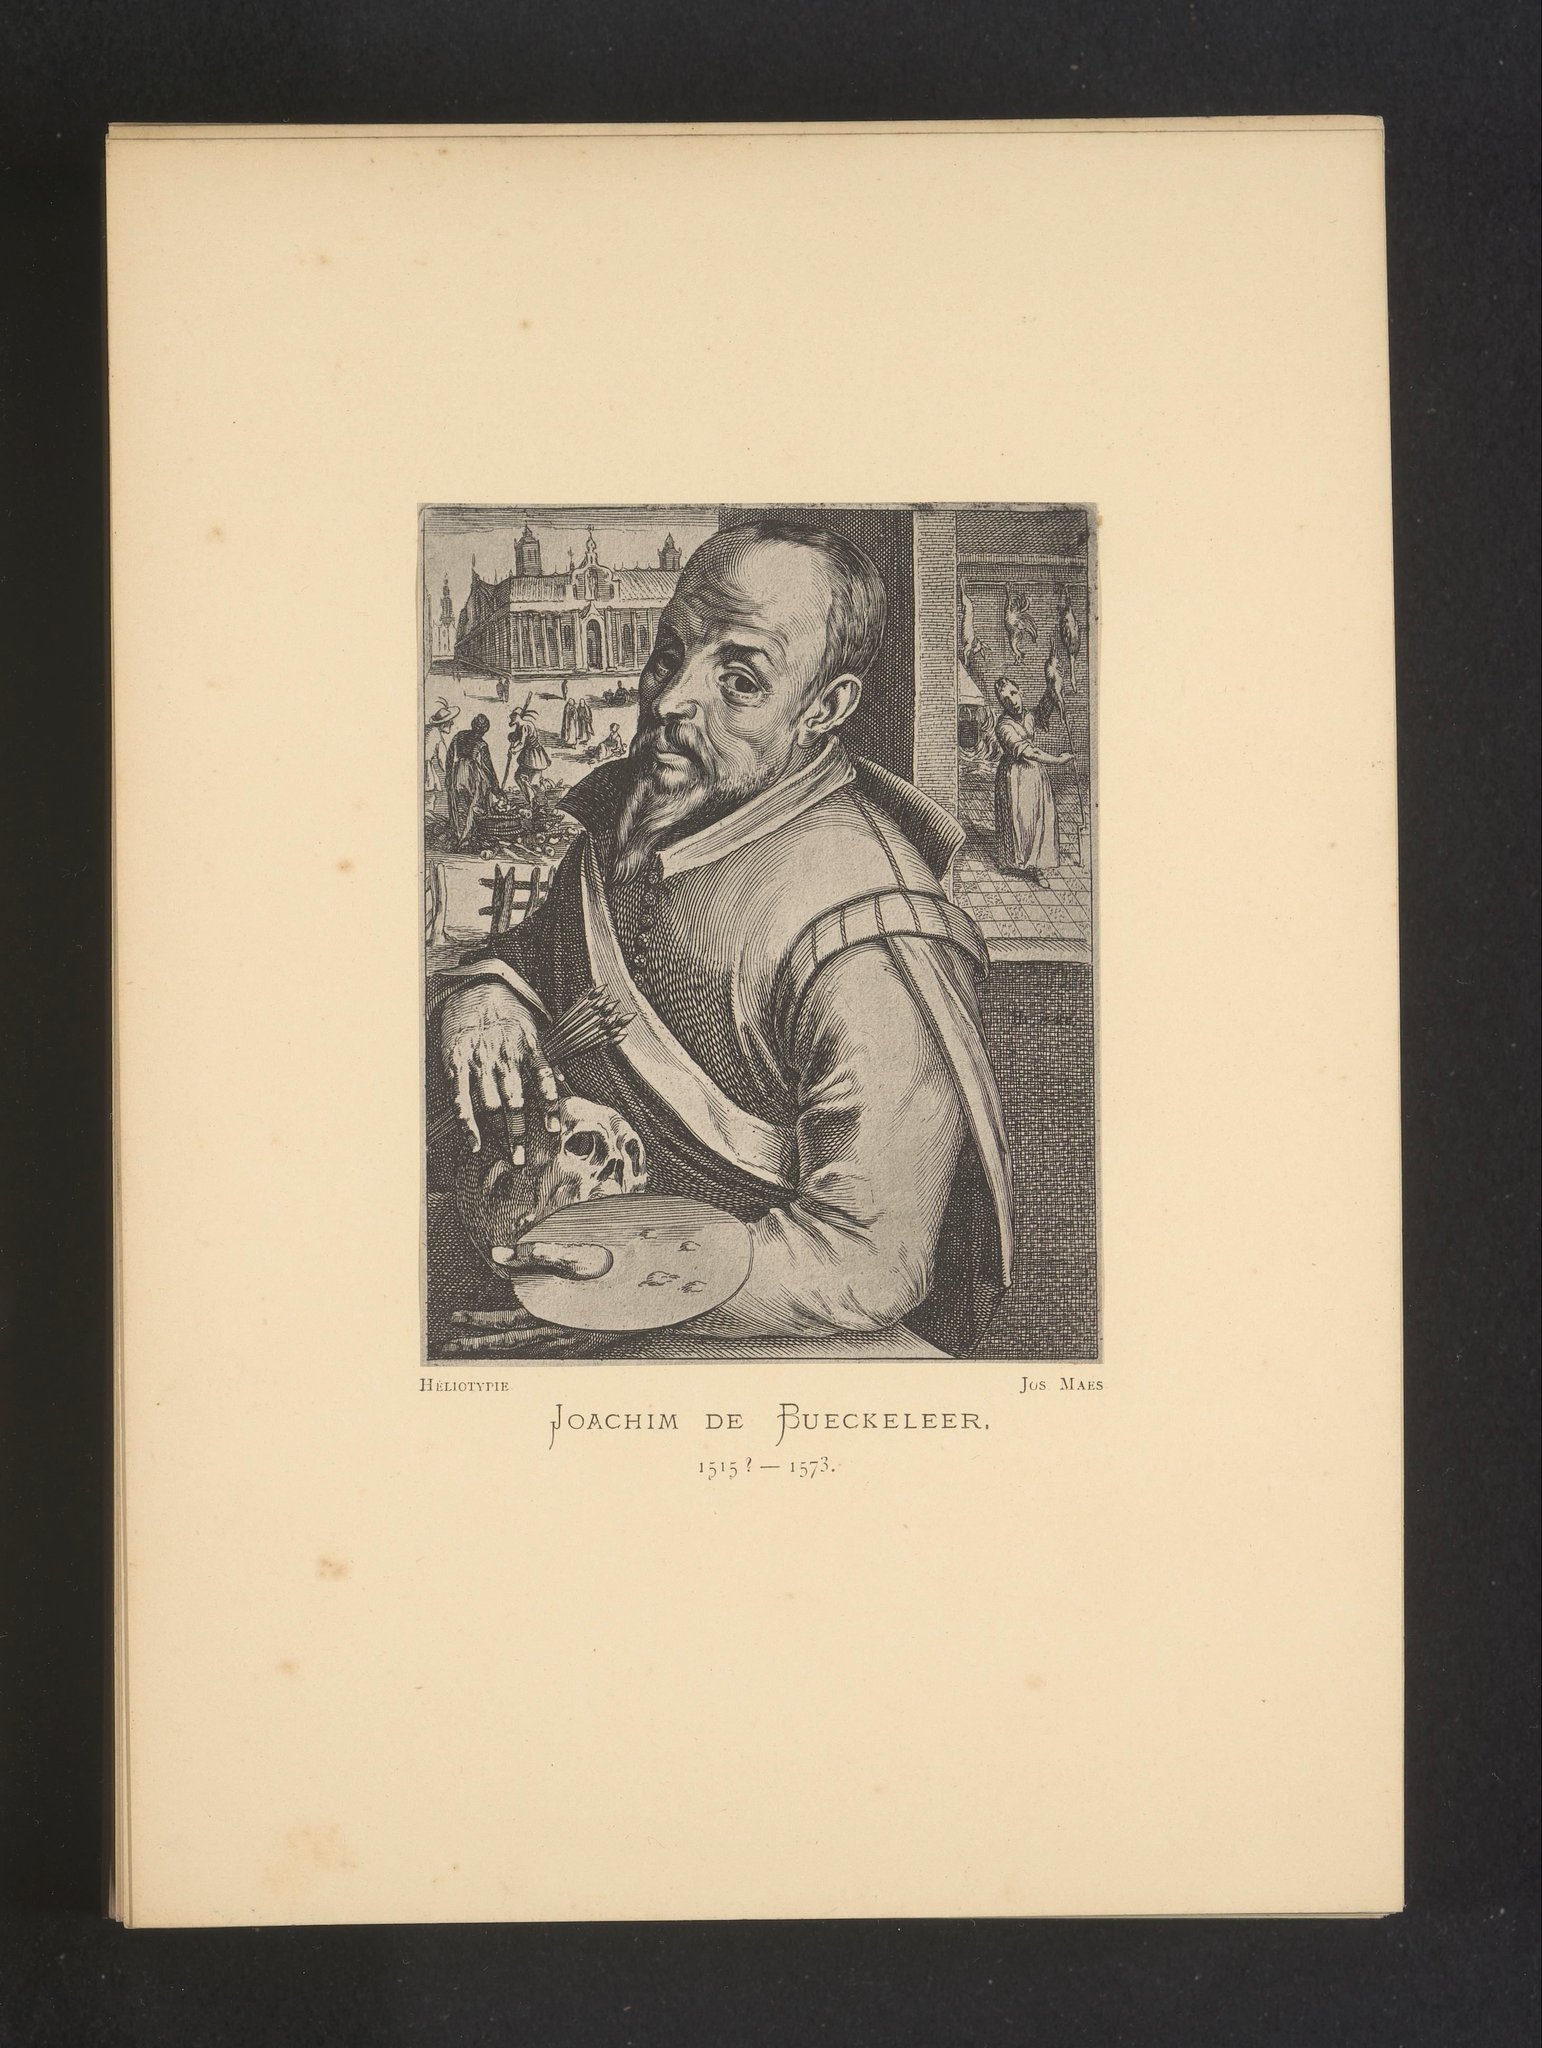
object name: photomechanical print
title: Joachim de Bueckeleer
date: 1872-1877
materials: cardboard, paper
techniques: photograph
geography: antwerp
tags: antwerp, draughtsman, joachim bueckelaer, historical persons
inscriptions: inscription: ‘1515? - 1573.’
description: Deze prent maakt deel uit van een omslag met 150 prenten en een katern met een lijst van afbeeldingen.